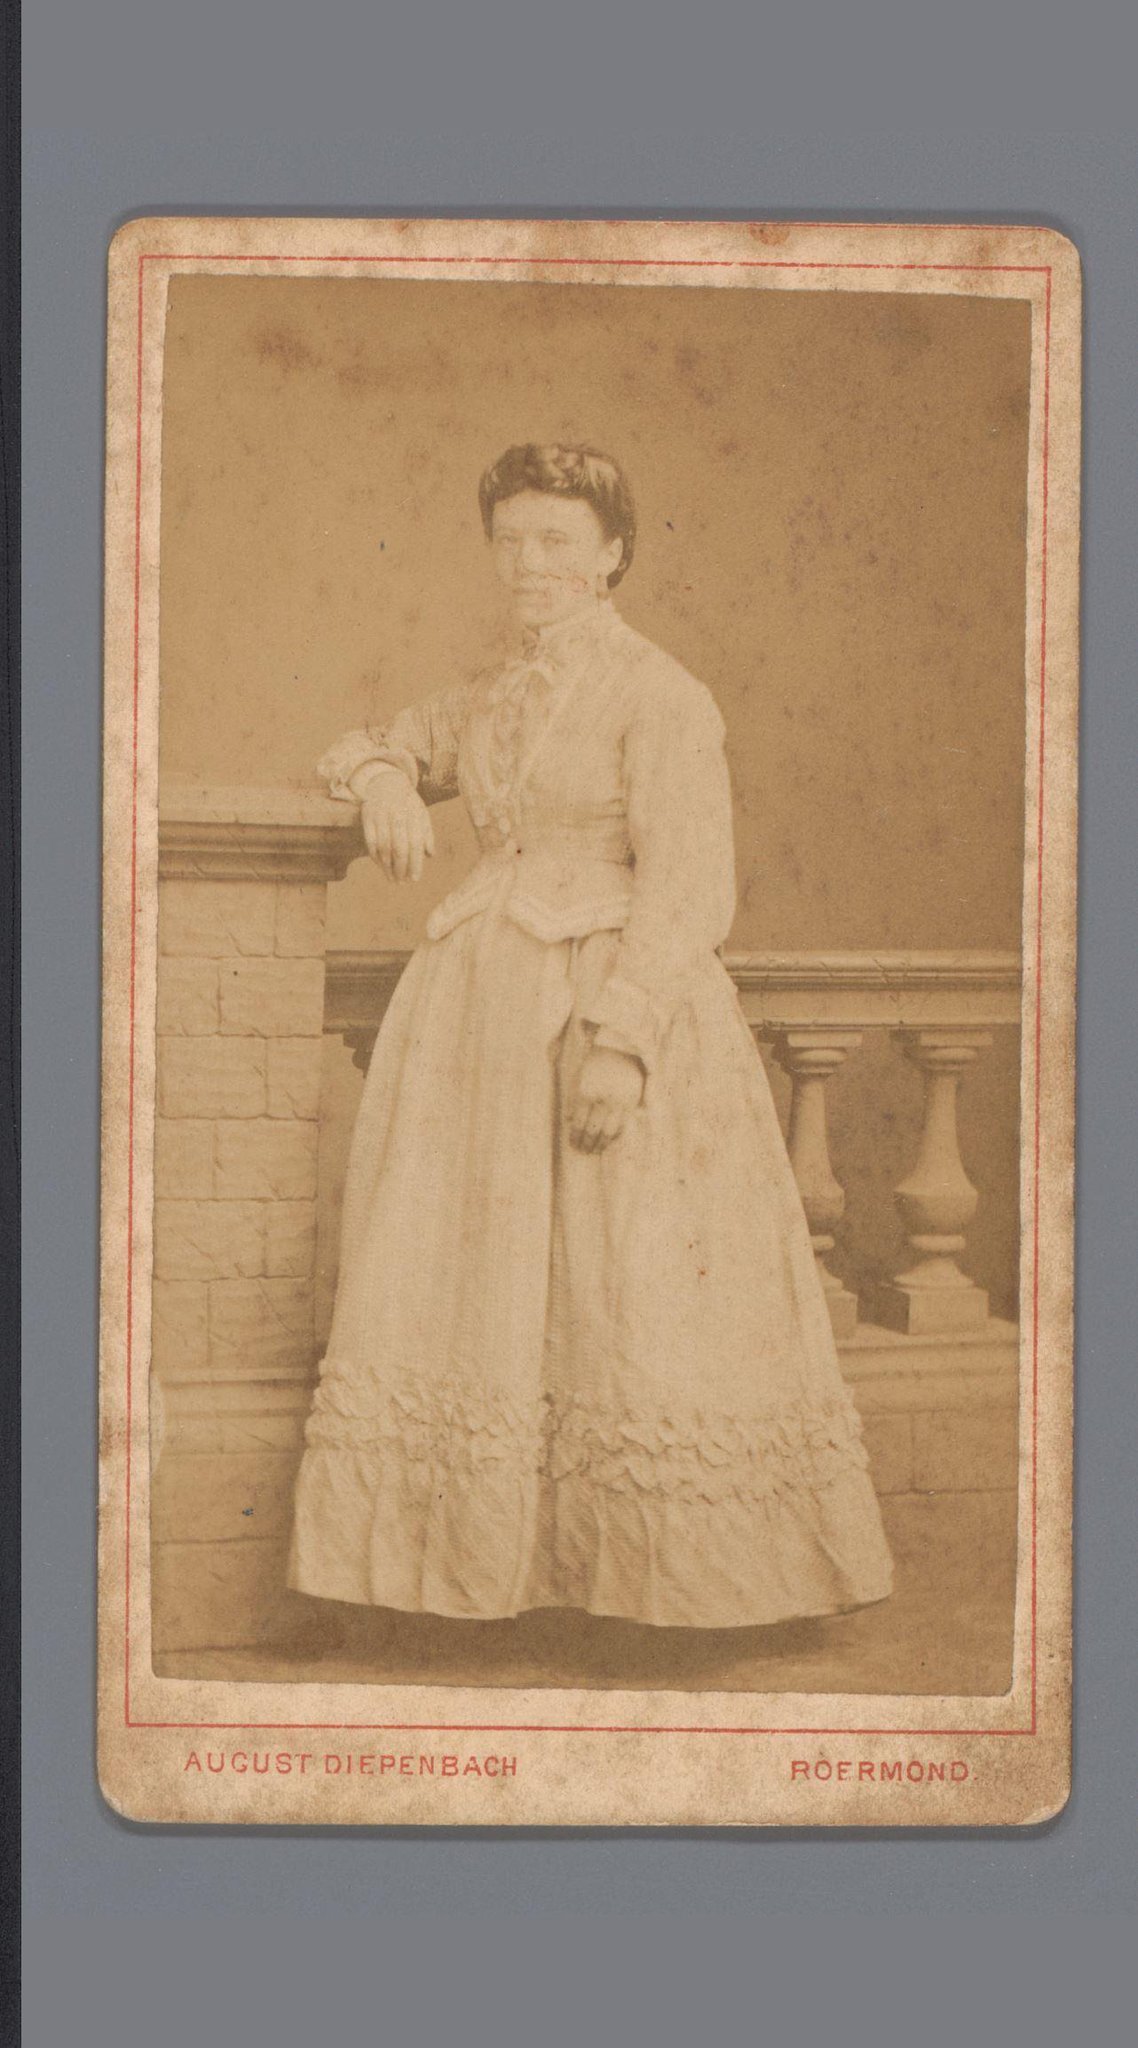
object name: carte de visite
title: Portret van een onbekende vrouw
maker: august diepenbach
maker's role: fotograaf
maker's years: 1837-1876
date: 1870-1876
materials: cardboard, paper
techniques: albumen print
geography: roermond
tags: adult woman, anonymous historical person portrayed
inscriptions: inscription: ‘De plaat blijft voor nabestelling bewaard.’